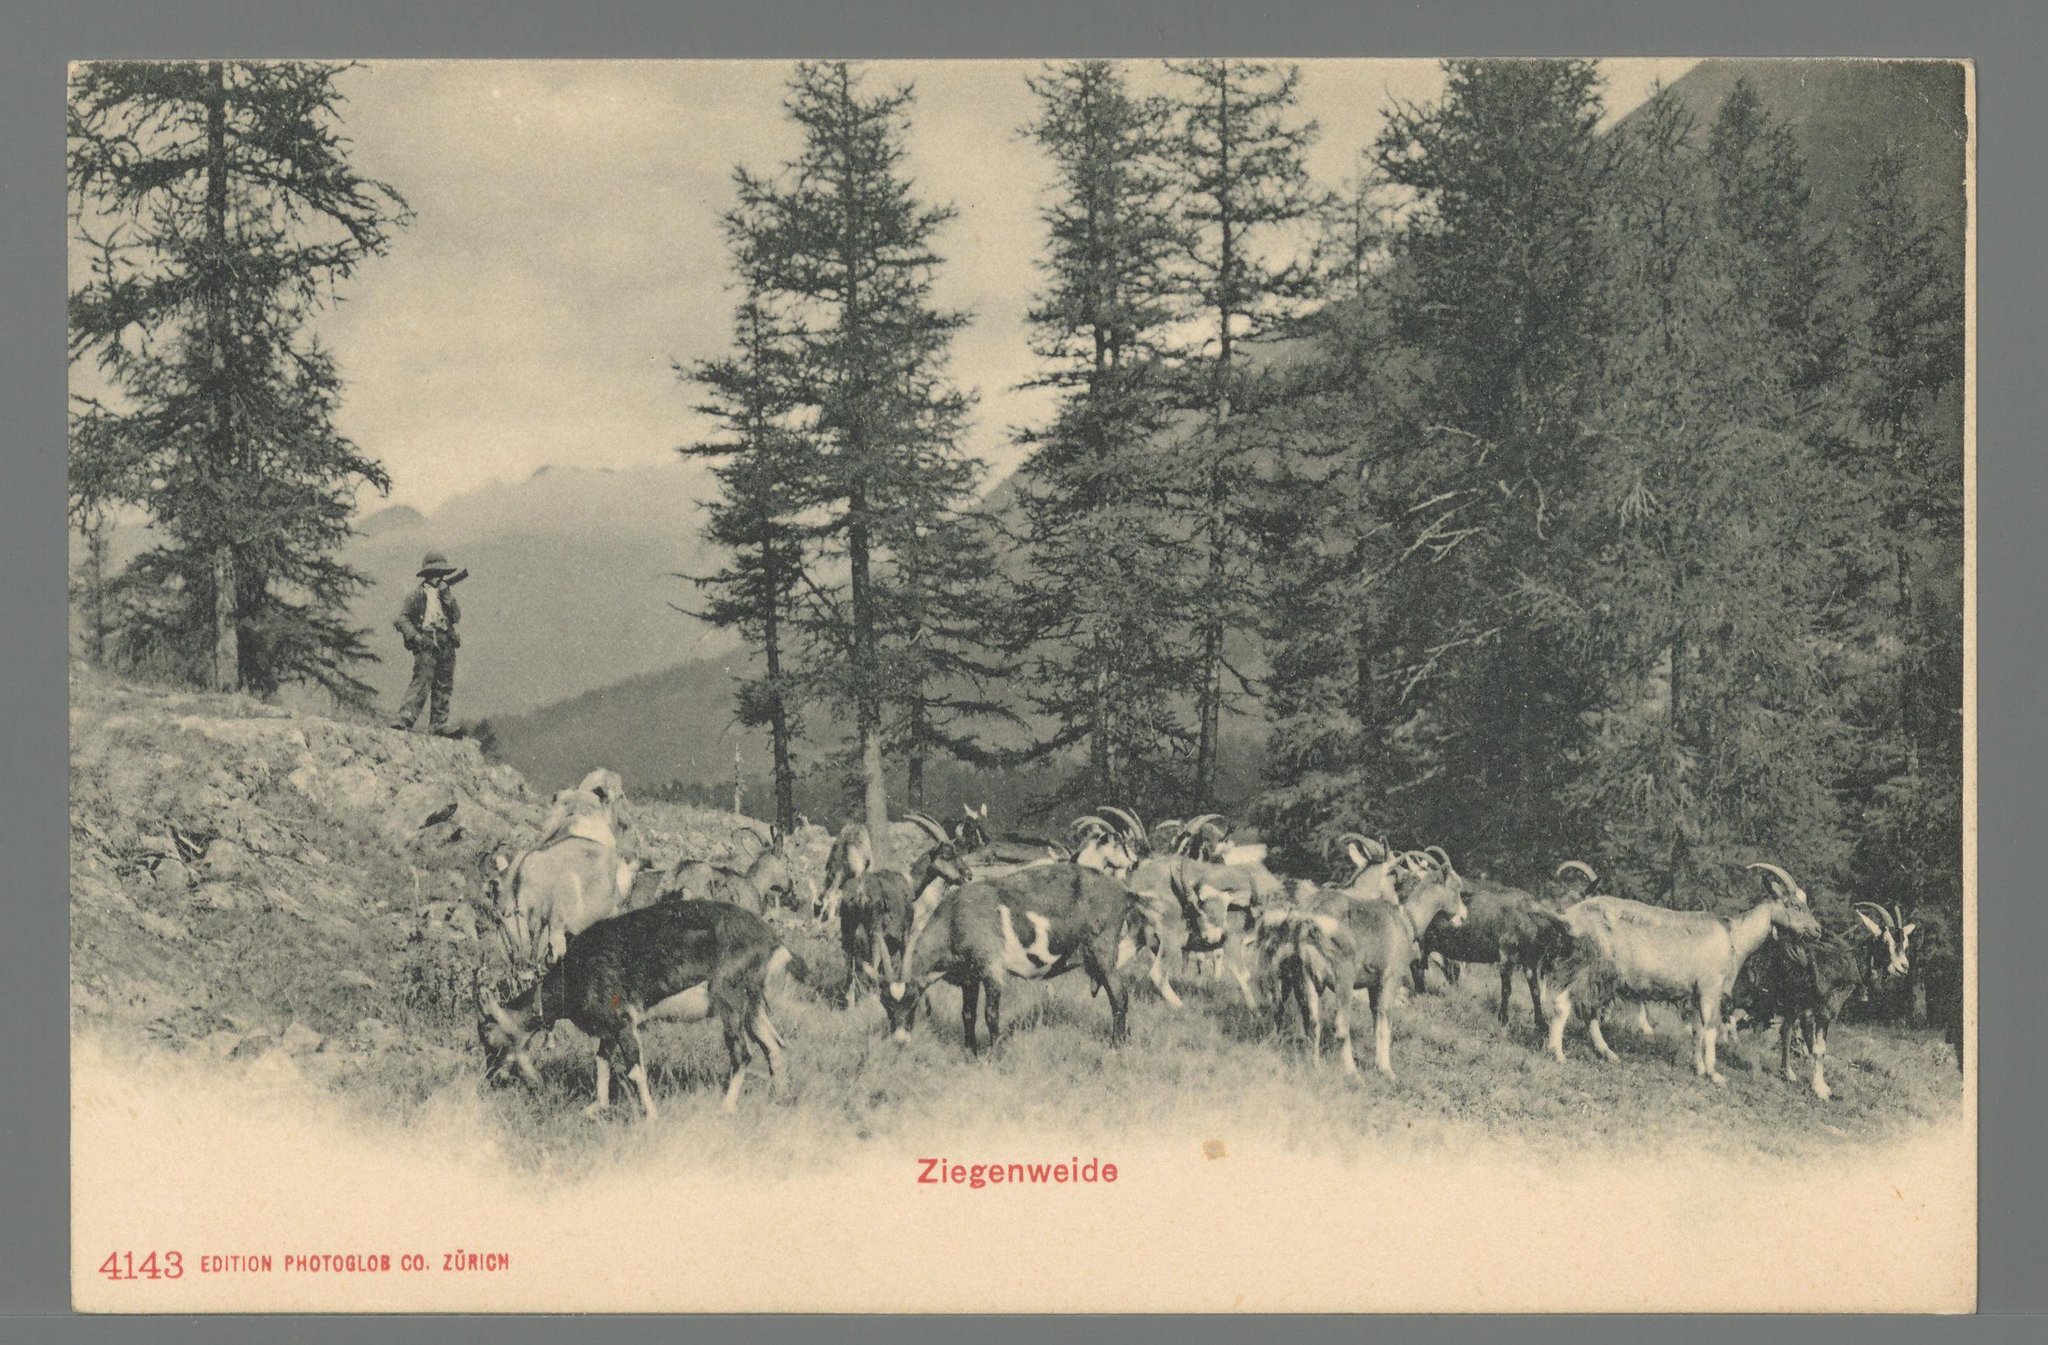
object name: photomechanical print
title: Ziegenweide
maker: Anonymous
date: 1895-1905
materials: cardboard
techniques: photograph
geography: zurich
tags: mountains (+ landscape with figures, staffage), goat, switzerland